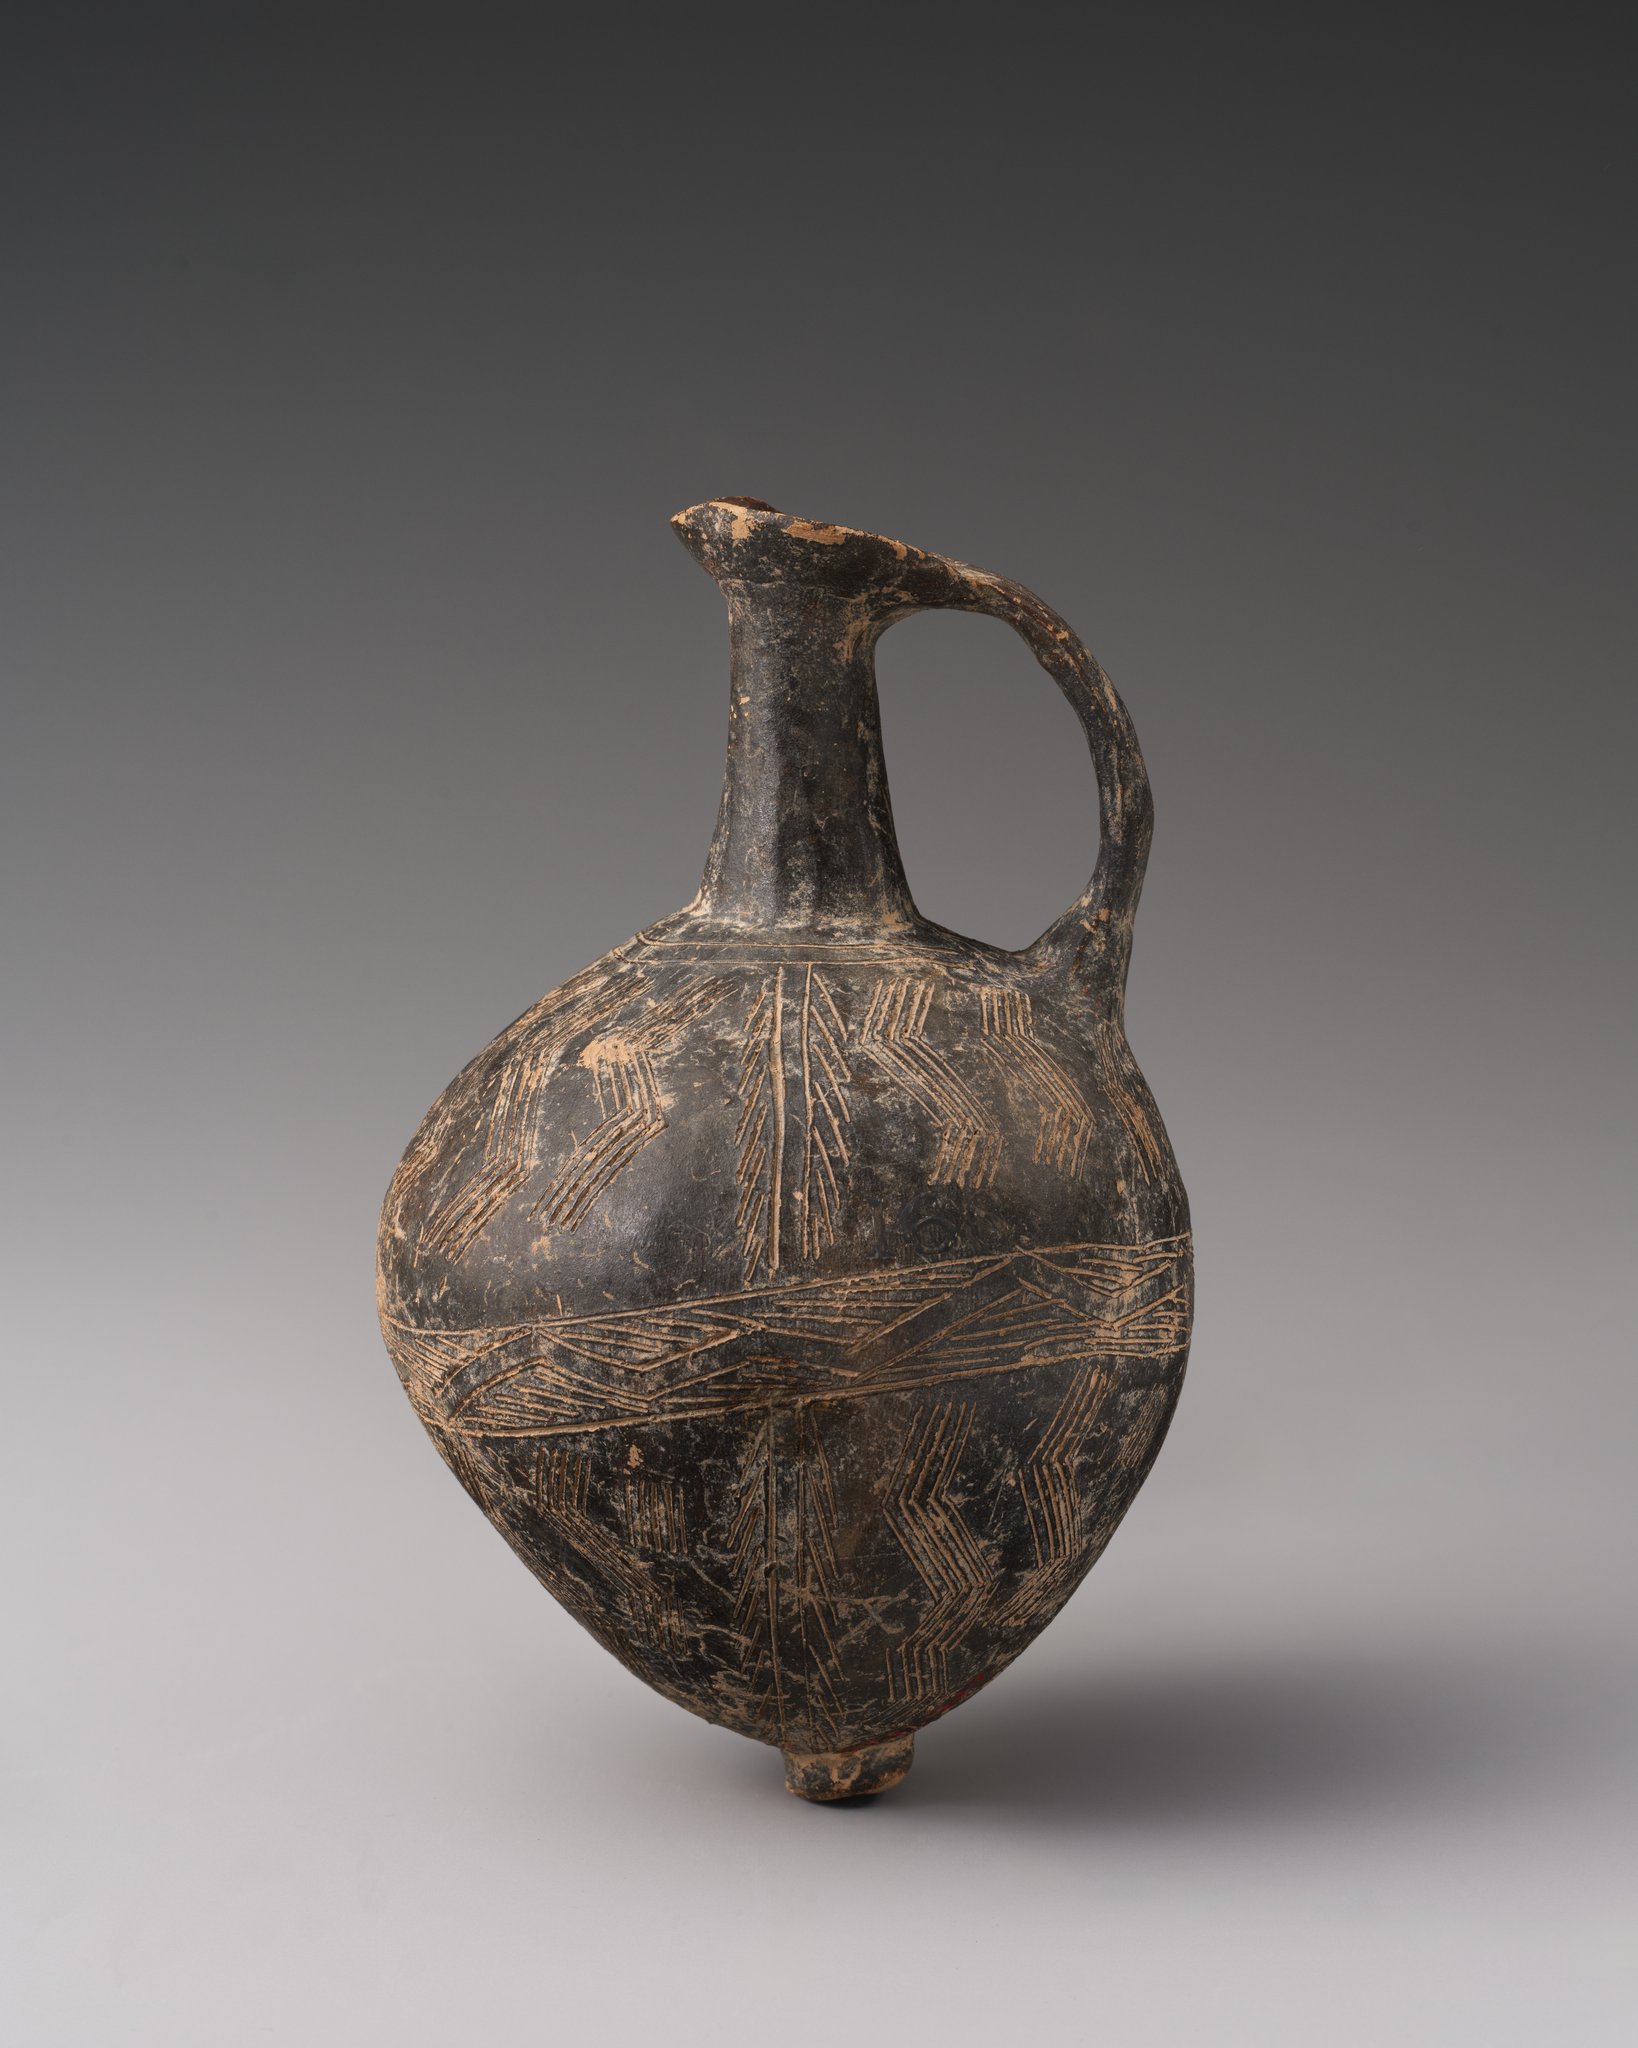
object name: jug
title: Terracotta jug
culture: cypriot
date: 1725-1600 BCE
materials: terracotta